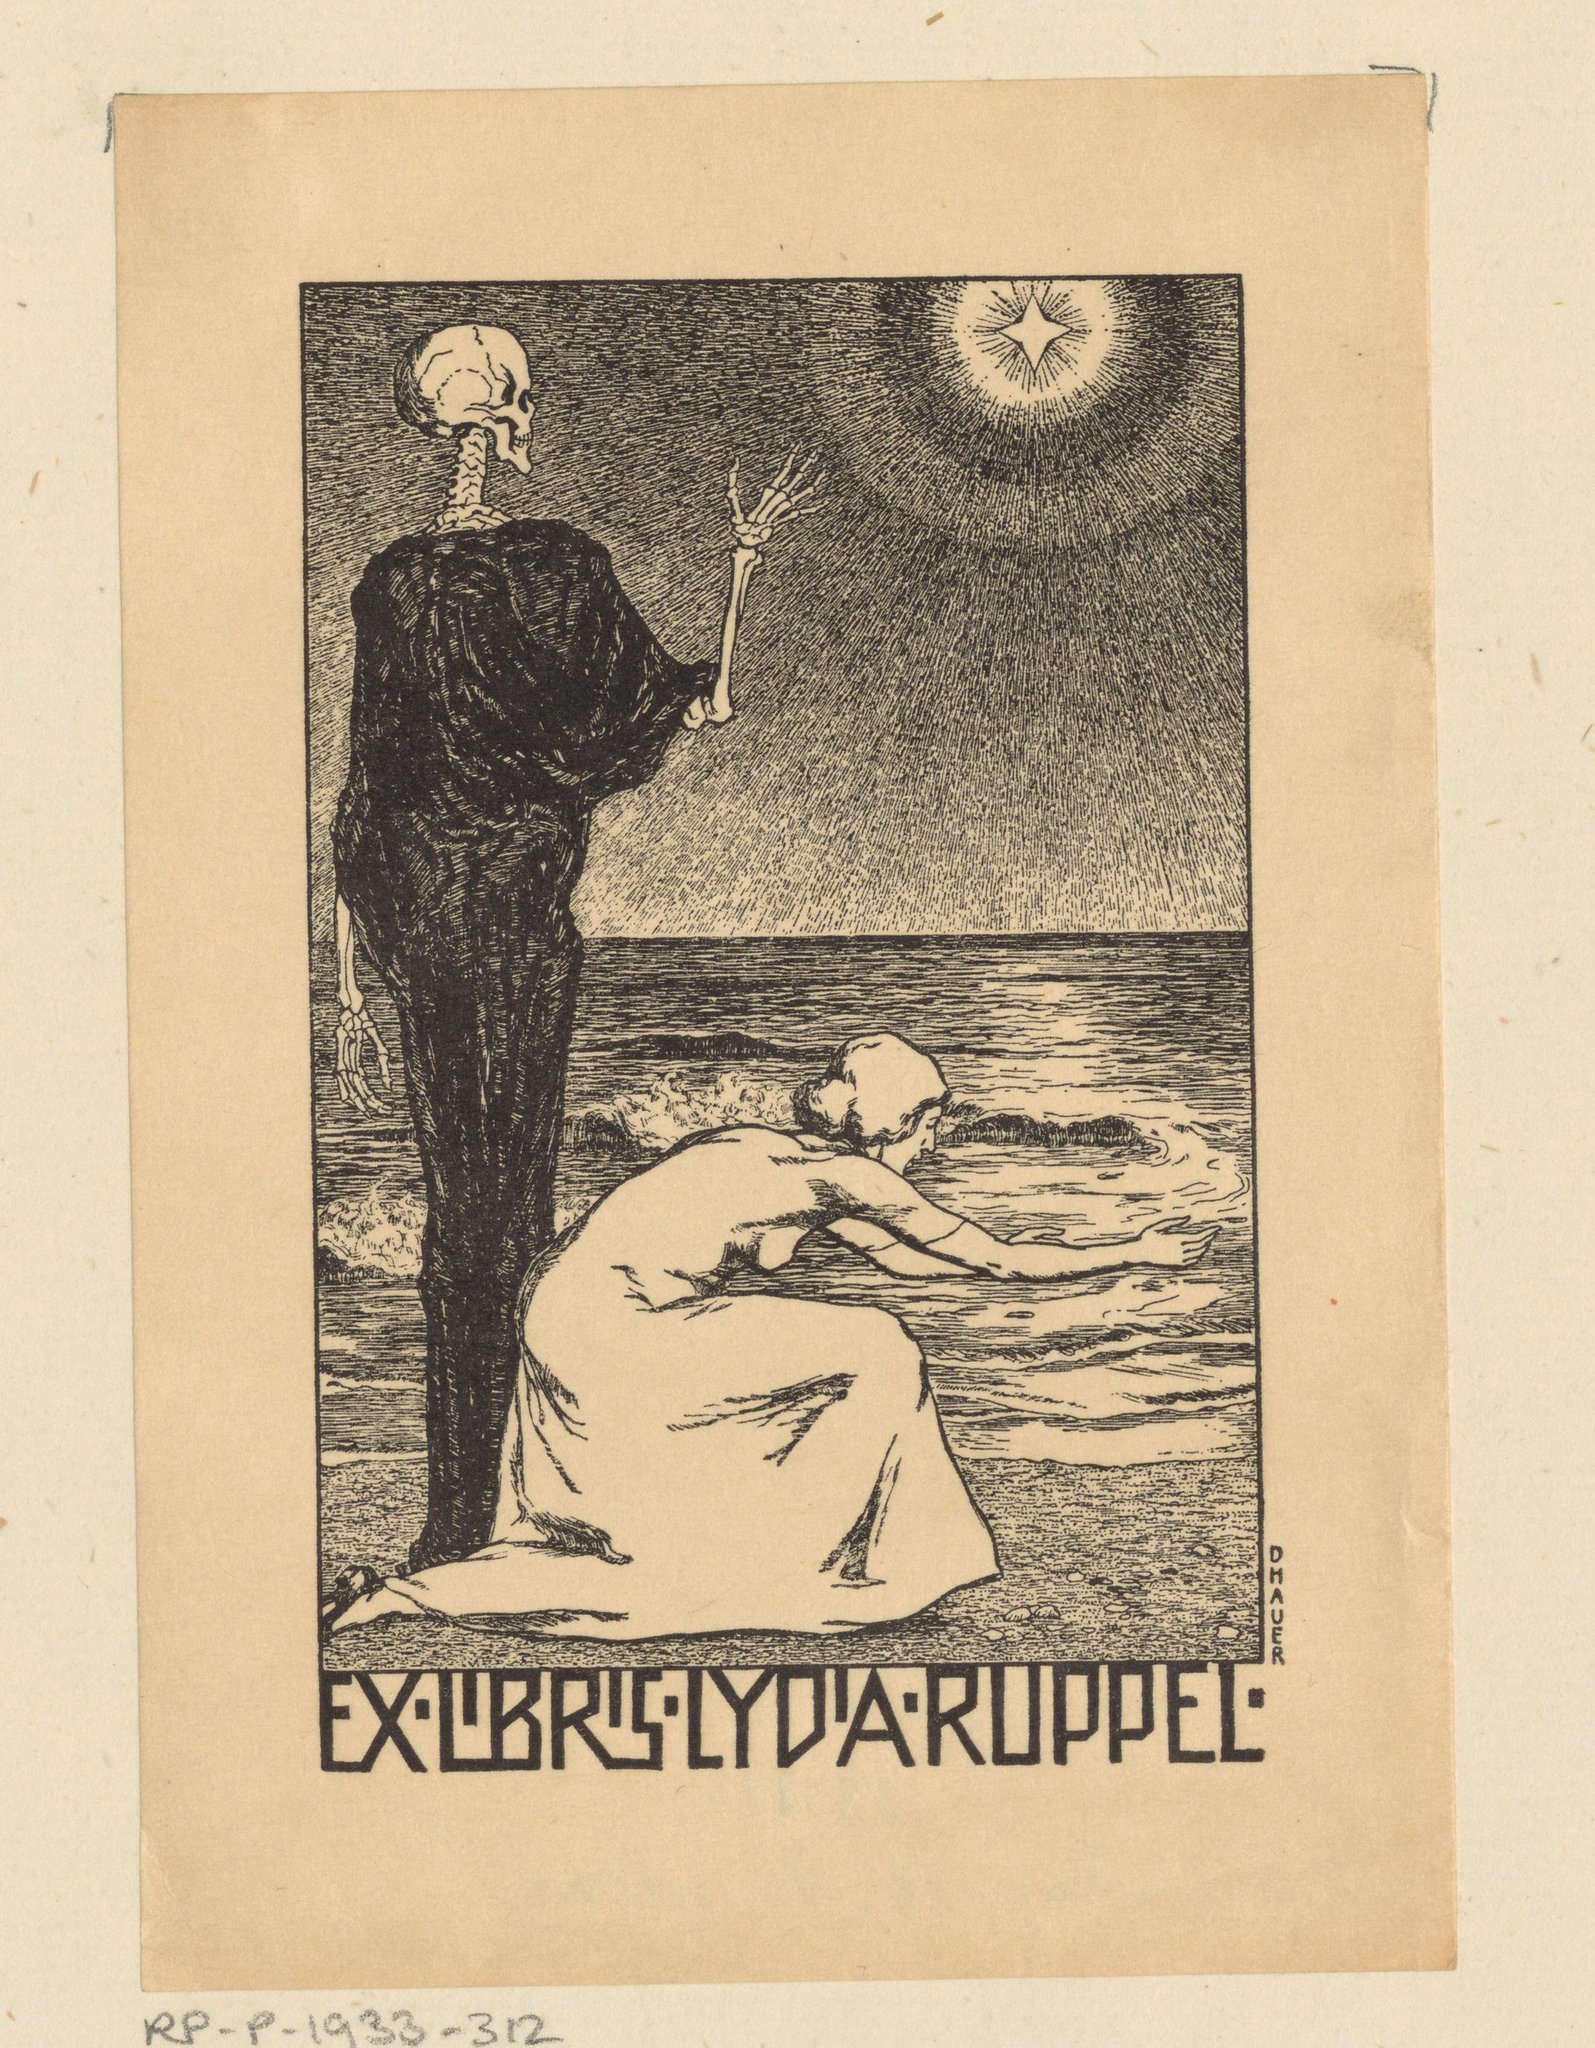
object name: bookplate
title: Ex libris van Lydia Ruppel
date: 1870-1933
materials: paper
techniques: printing block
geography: germany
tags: kneeling figure - aa - female human figure, death as skeleton, stars, sea